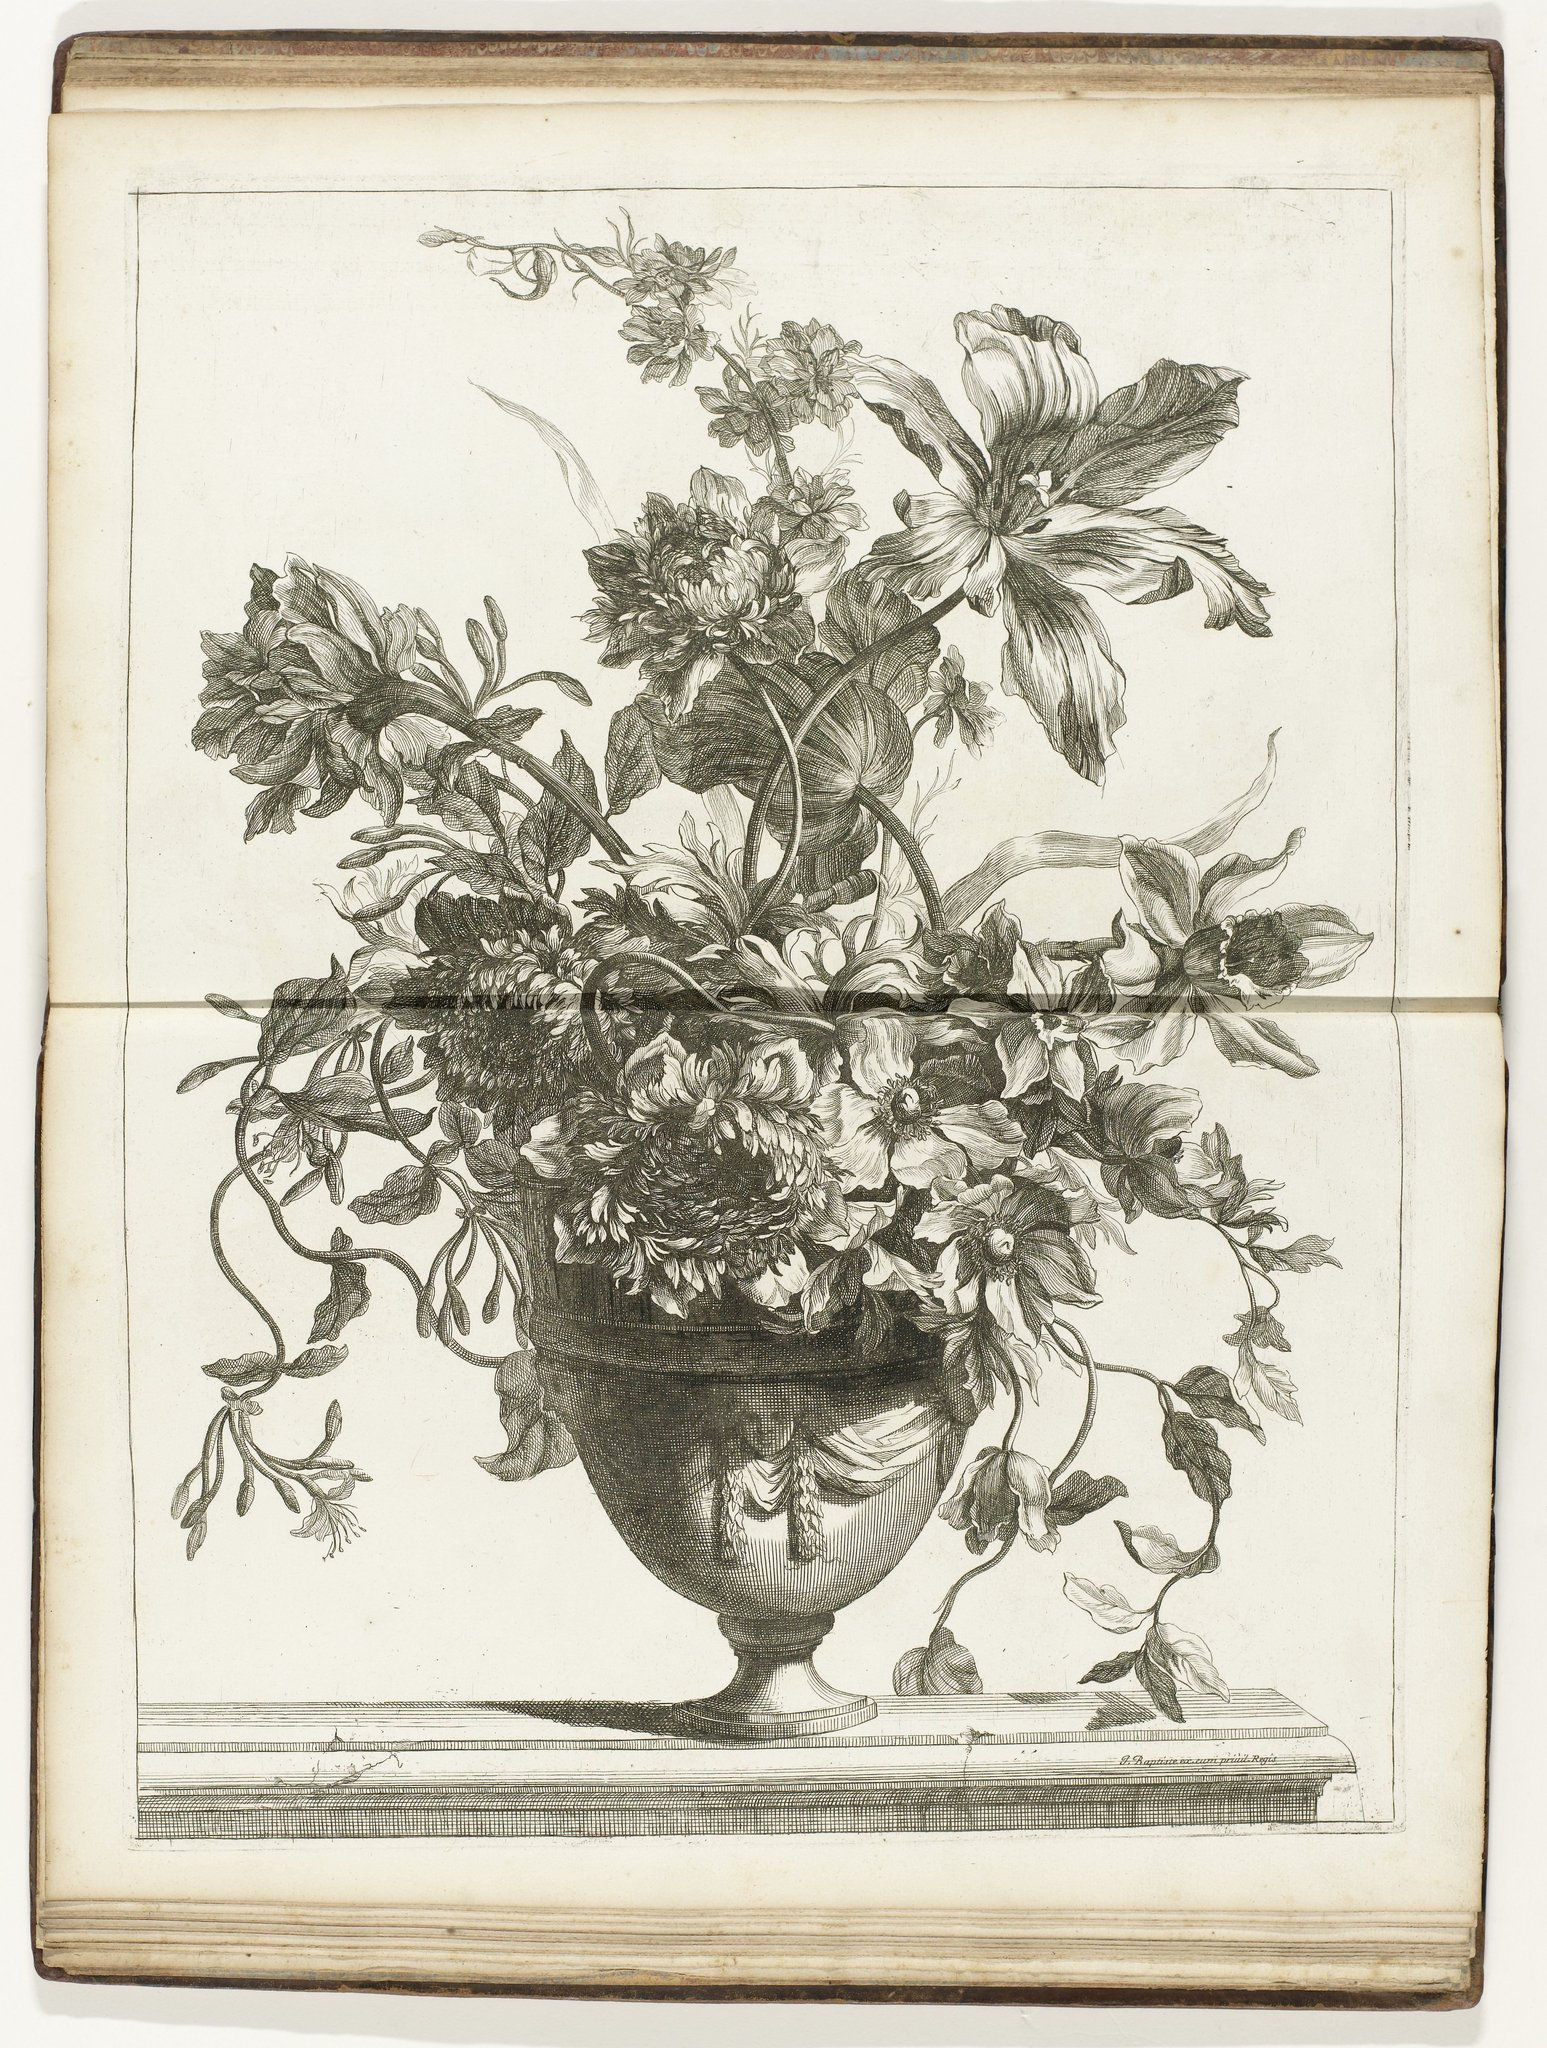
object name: print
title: Livres de Plusieurs Vaze de Fleurs faicts d'Apres le Naturel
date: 1680-1695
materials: paper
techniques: etching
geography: paris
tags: flowers in a vase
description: Bloemenvaas waarin bloemen. Prent maakt deel uit van een album.